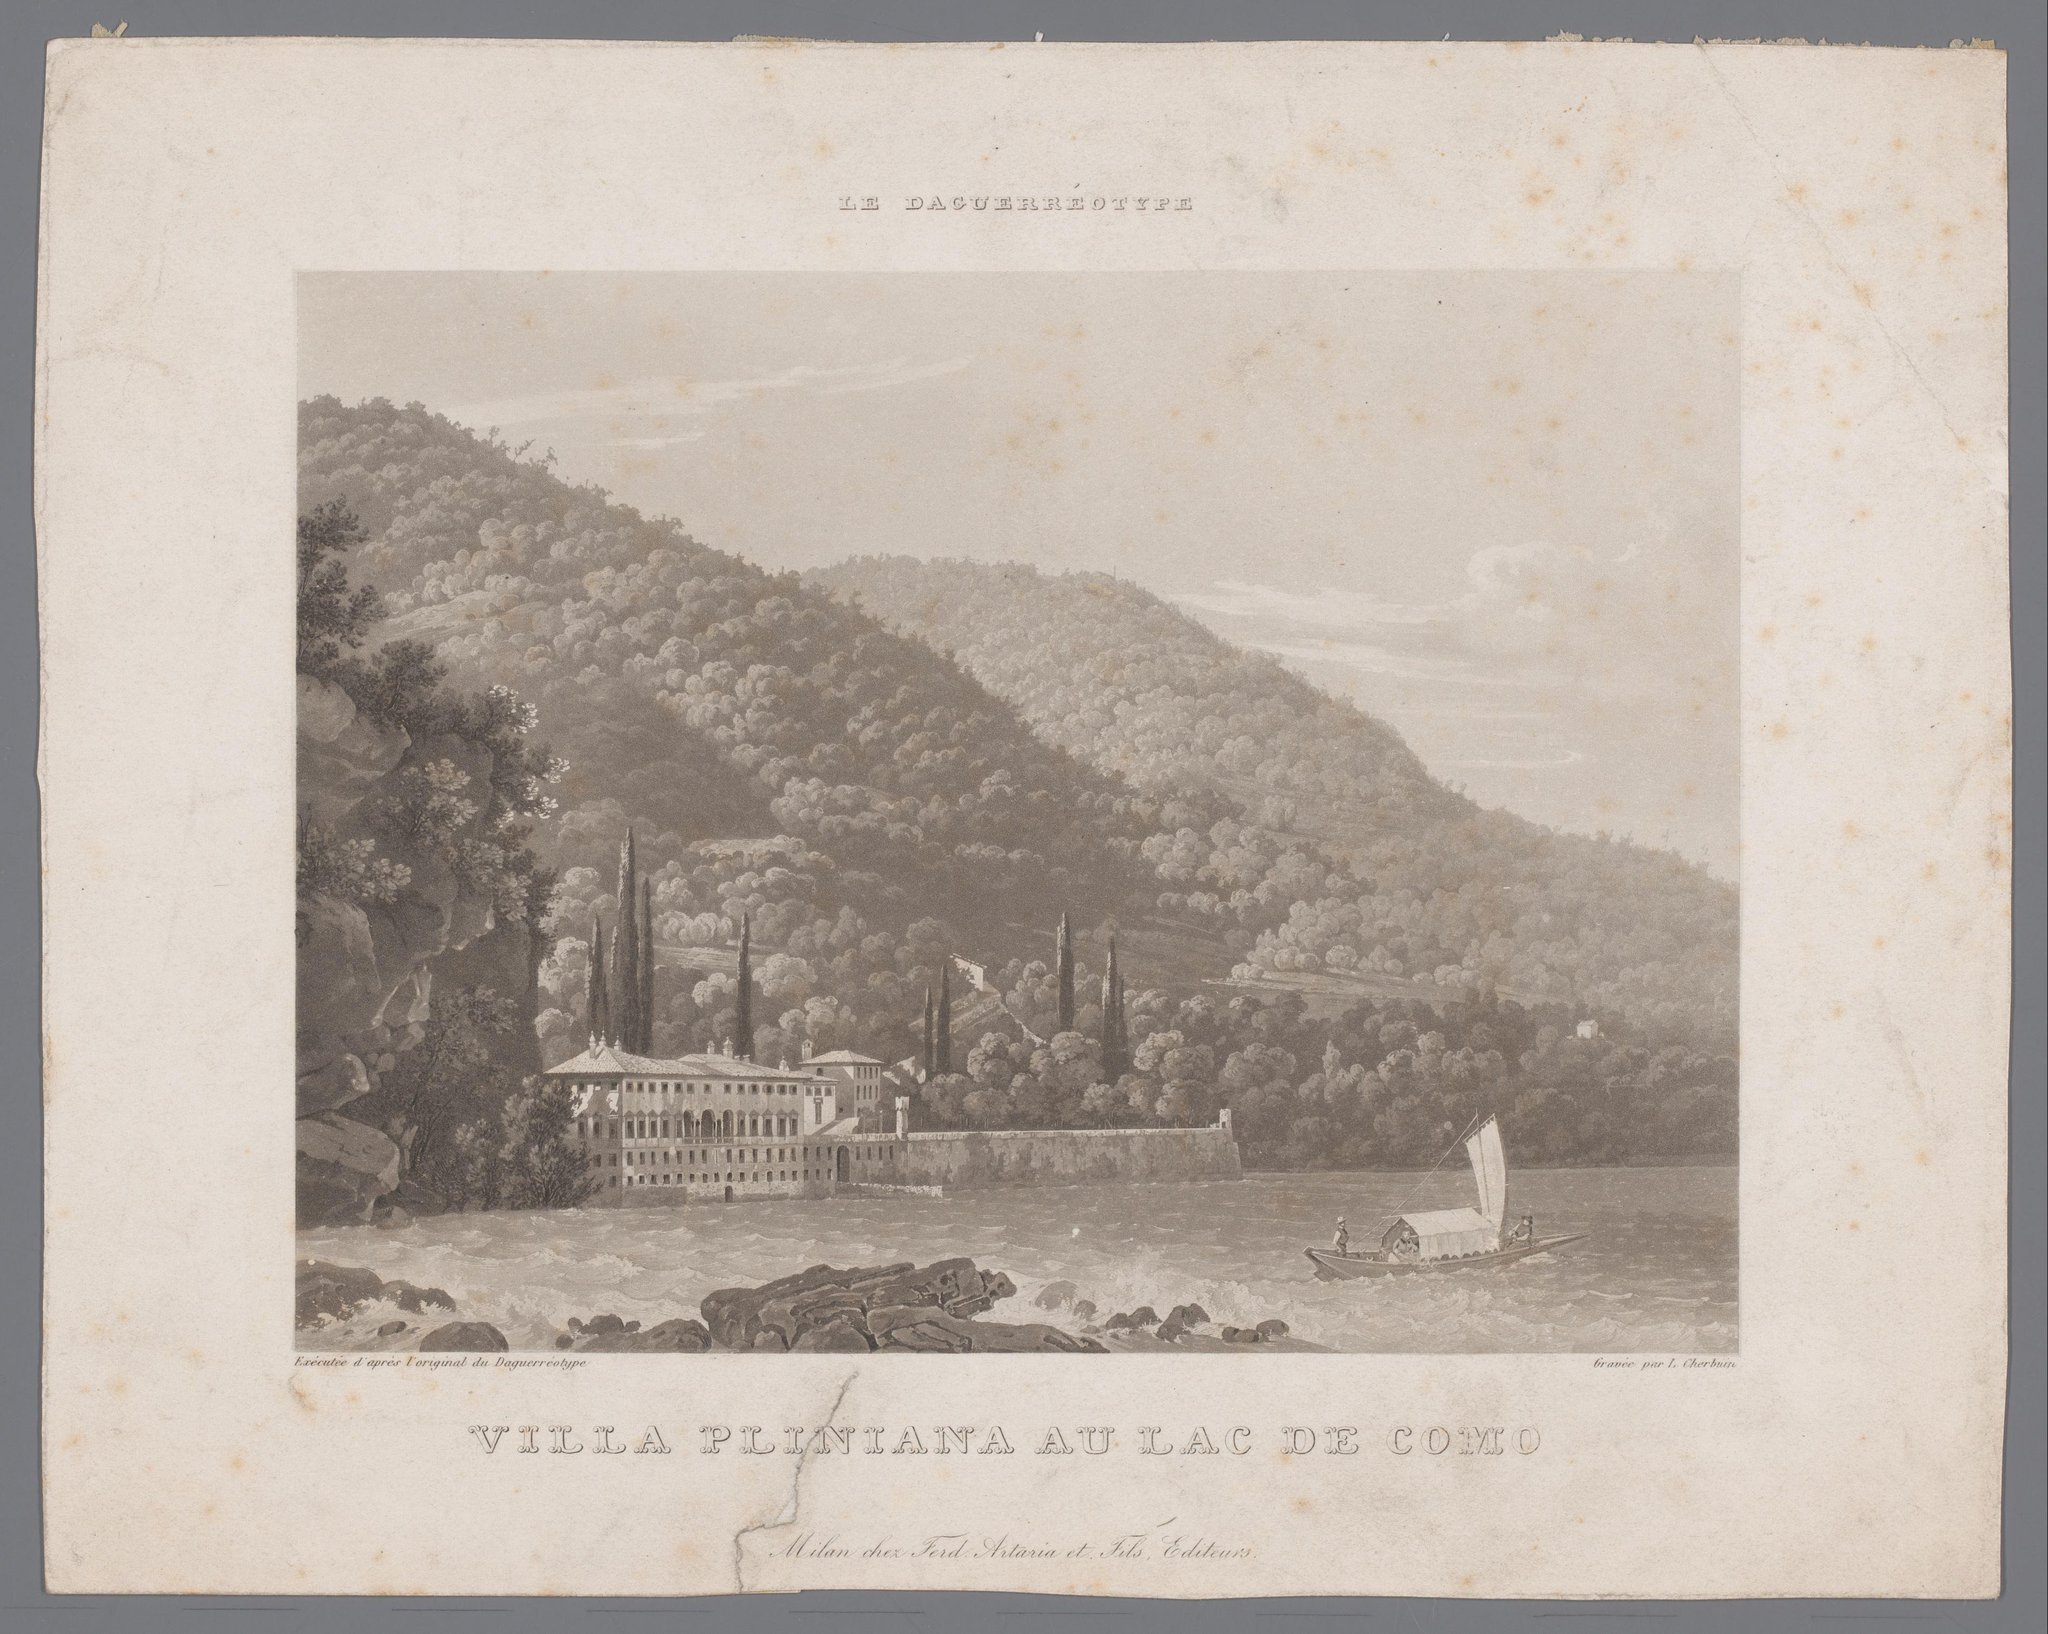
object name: print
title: Le daguerréotype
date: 1840-1847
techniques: aquatint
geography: milan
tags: rural housing, e.g. country-house, villa, cottage, lake